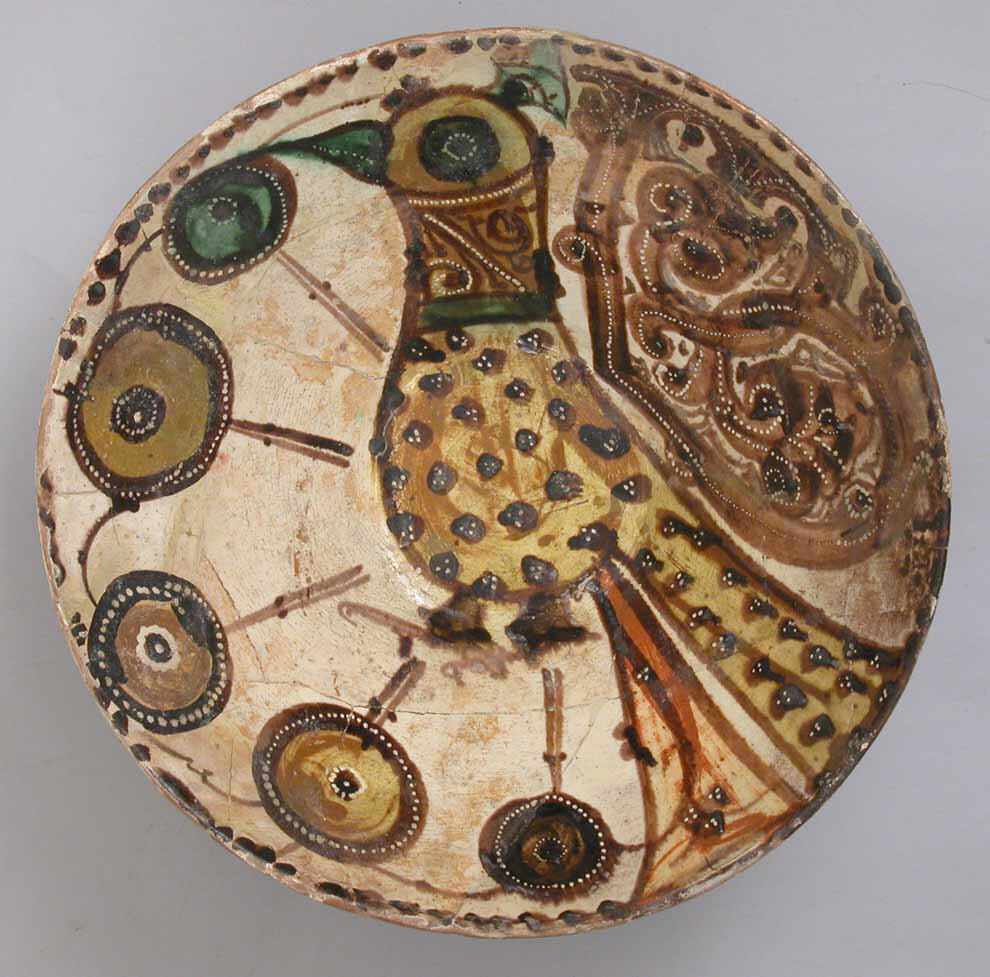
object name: bowl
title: Earthenware Bowl with White slip and Polychrome Decoration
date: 1001-1100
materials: earthenware, glaze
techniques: polychrome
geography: iran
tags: birds